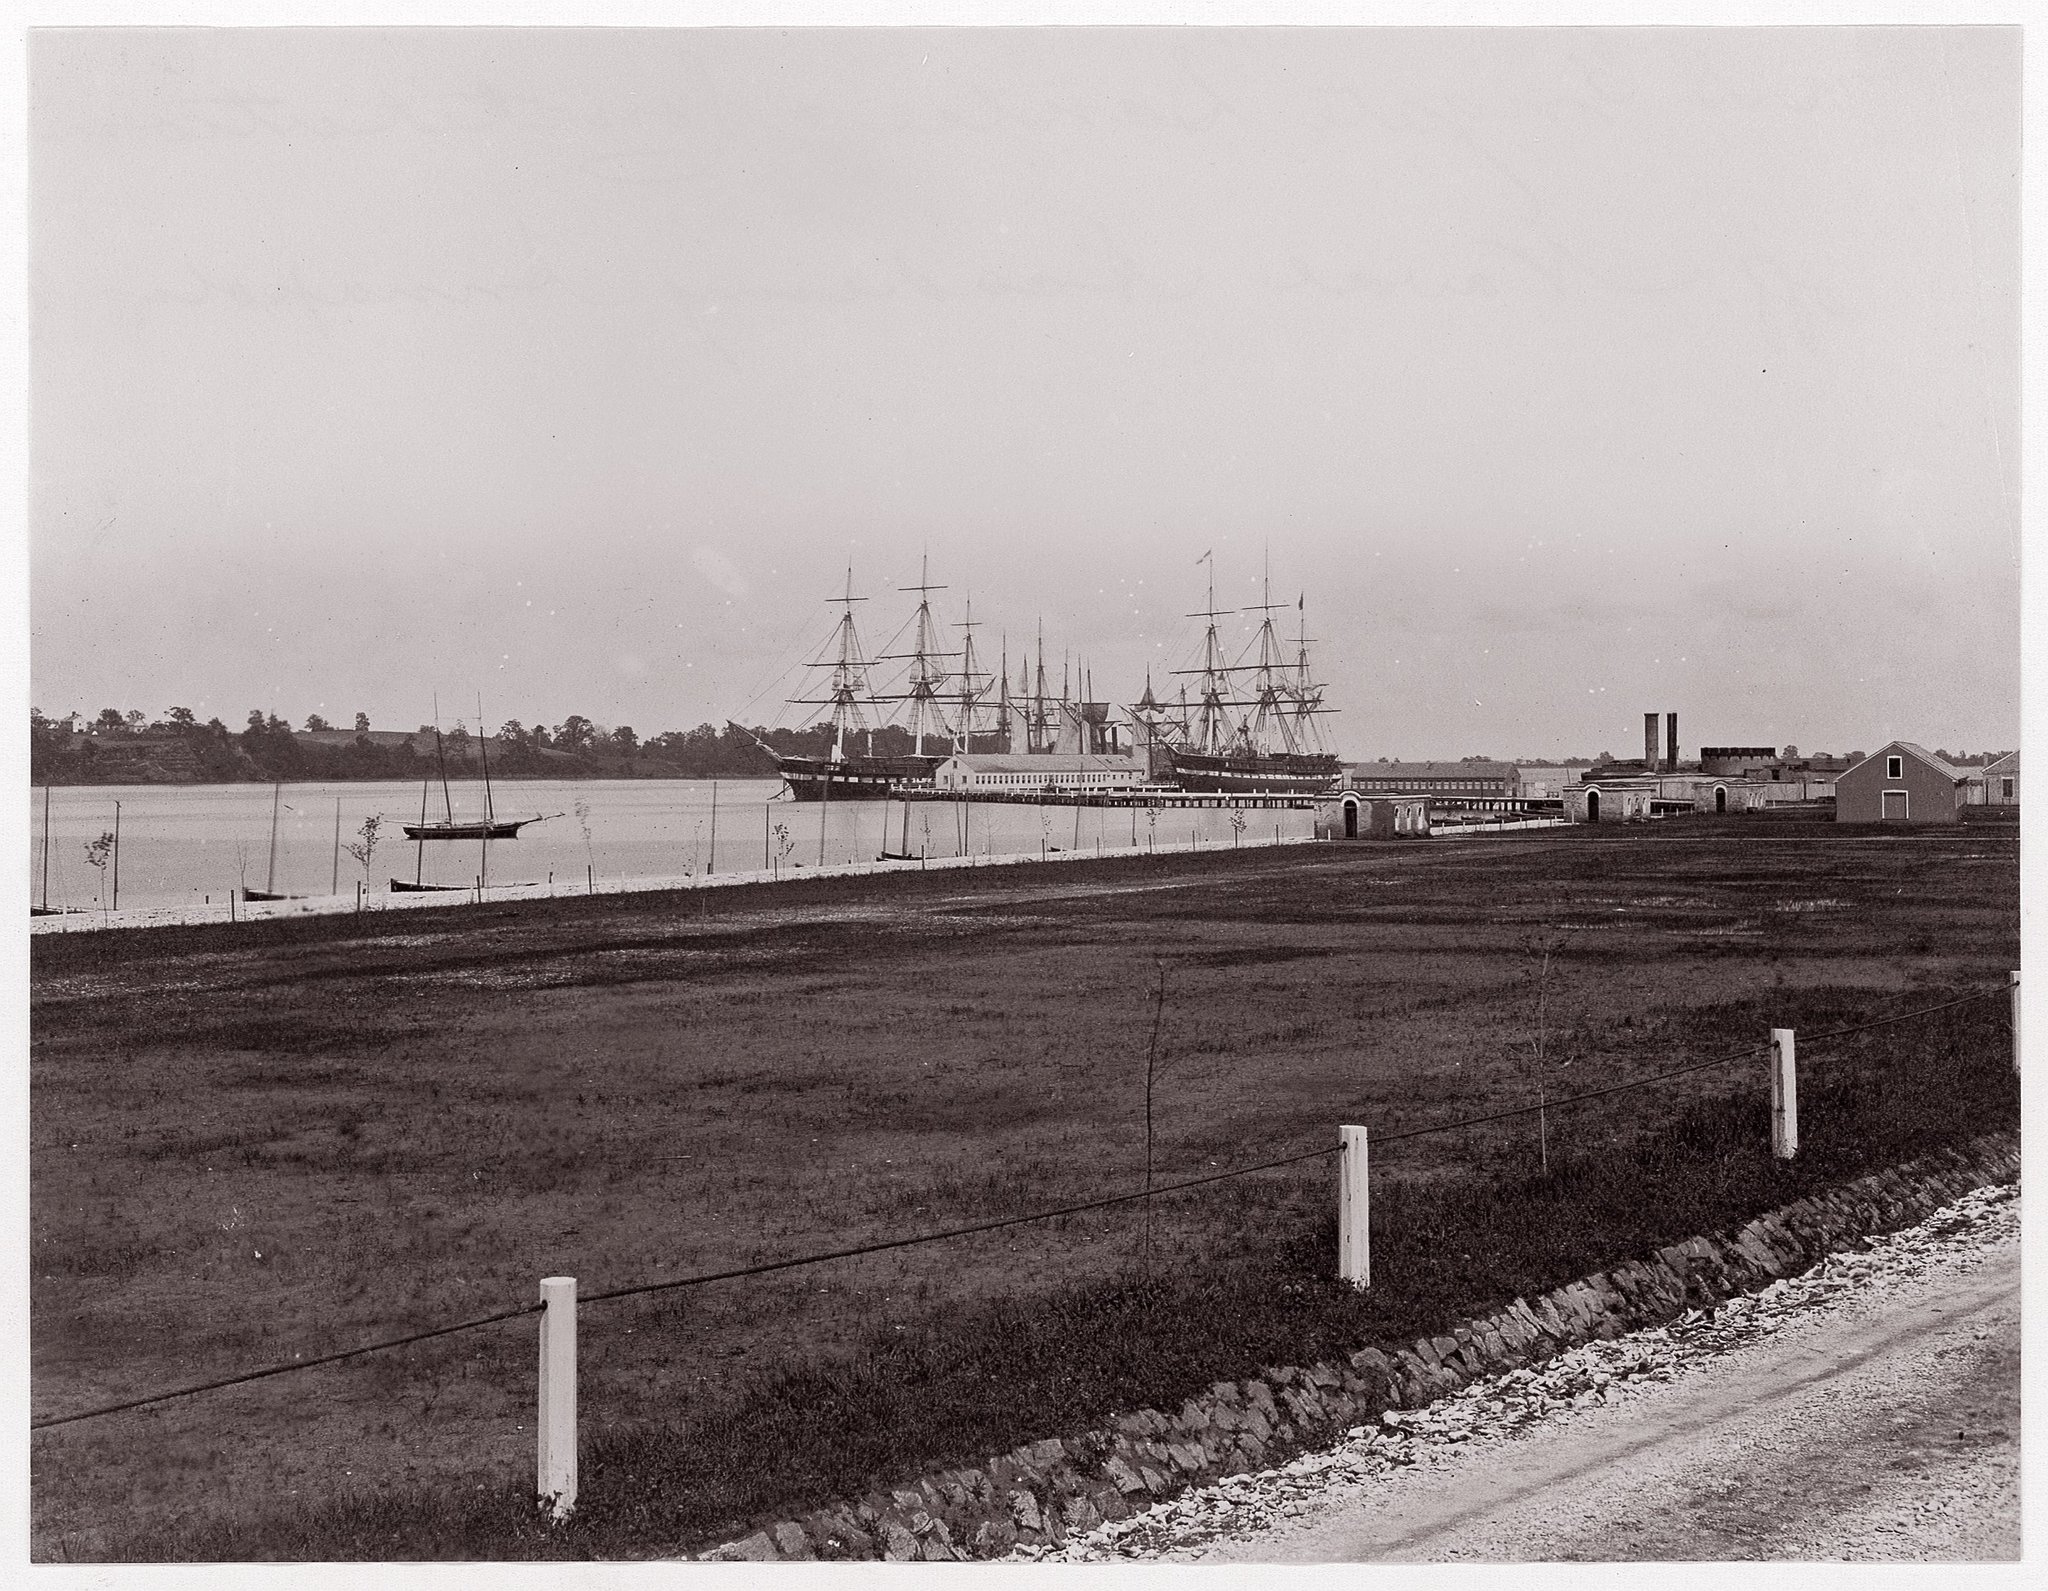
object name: photograph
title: Frigates "Santee" and "Constitution" off Naval Academy, Annapolis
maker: Anonymous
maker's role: artist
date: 1861-1865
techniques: albumen silver print, glass negative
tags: american civil war,ships